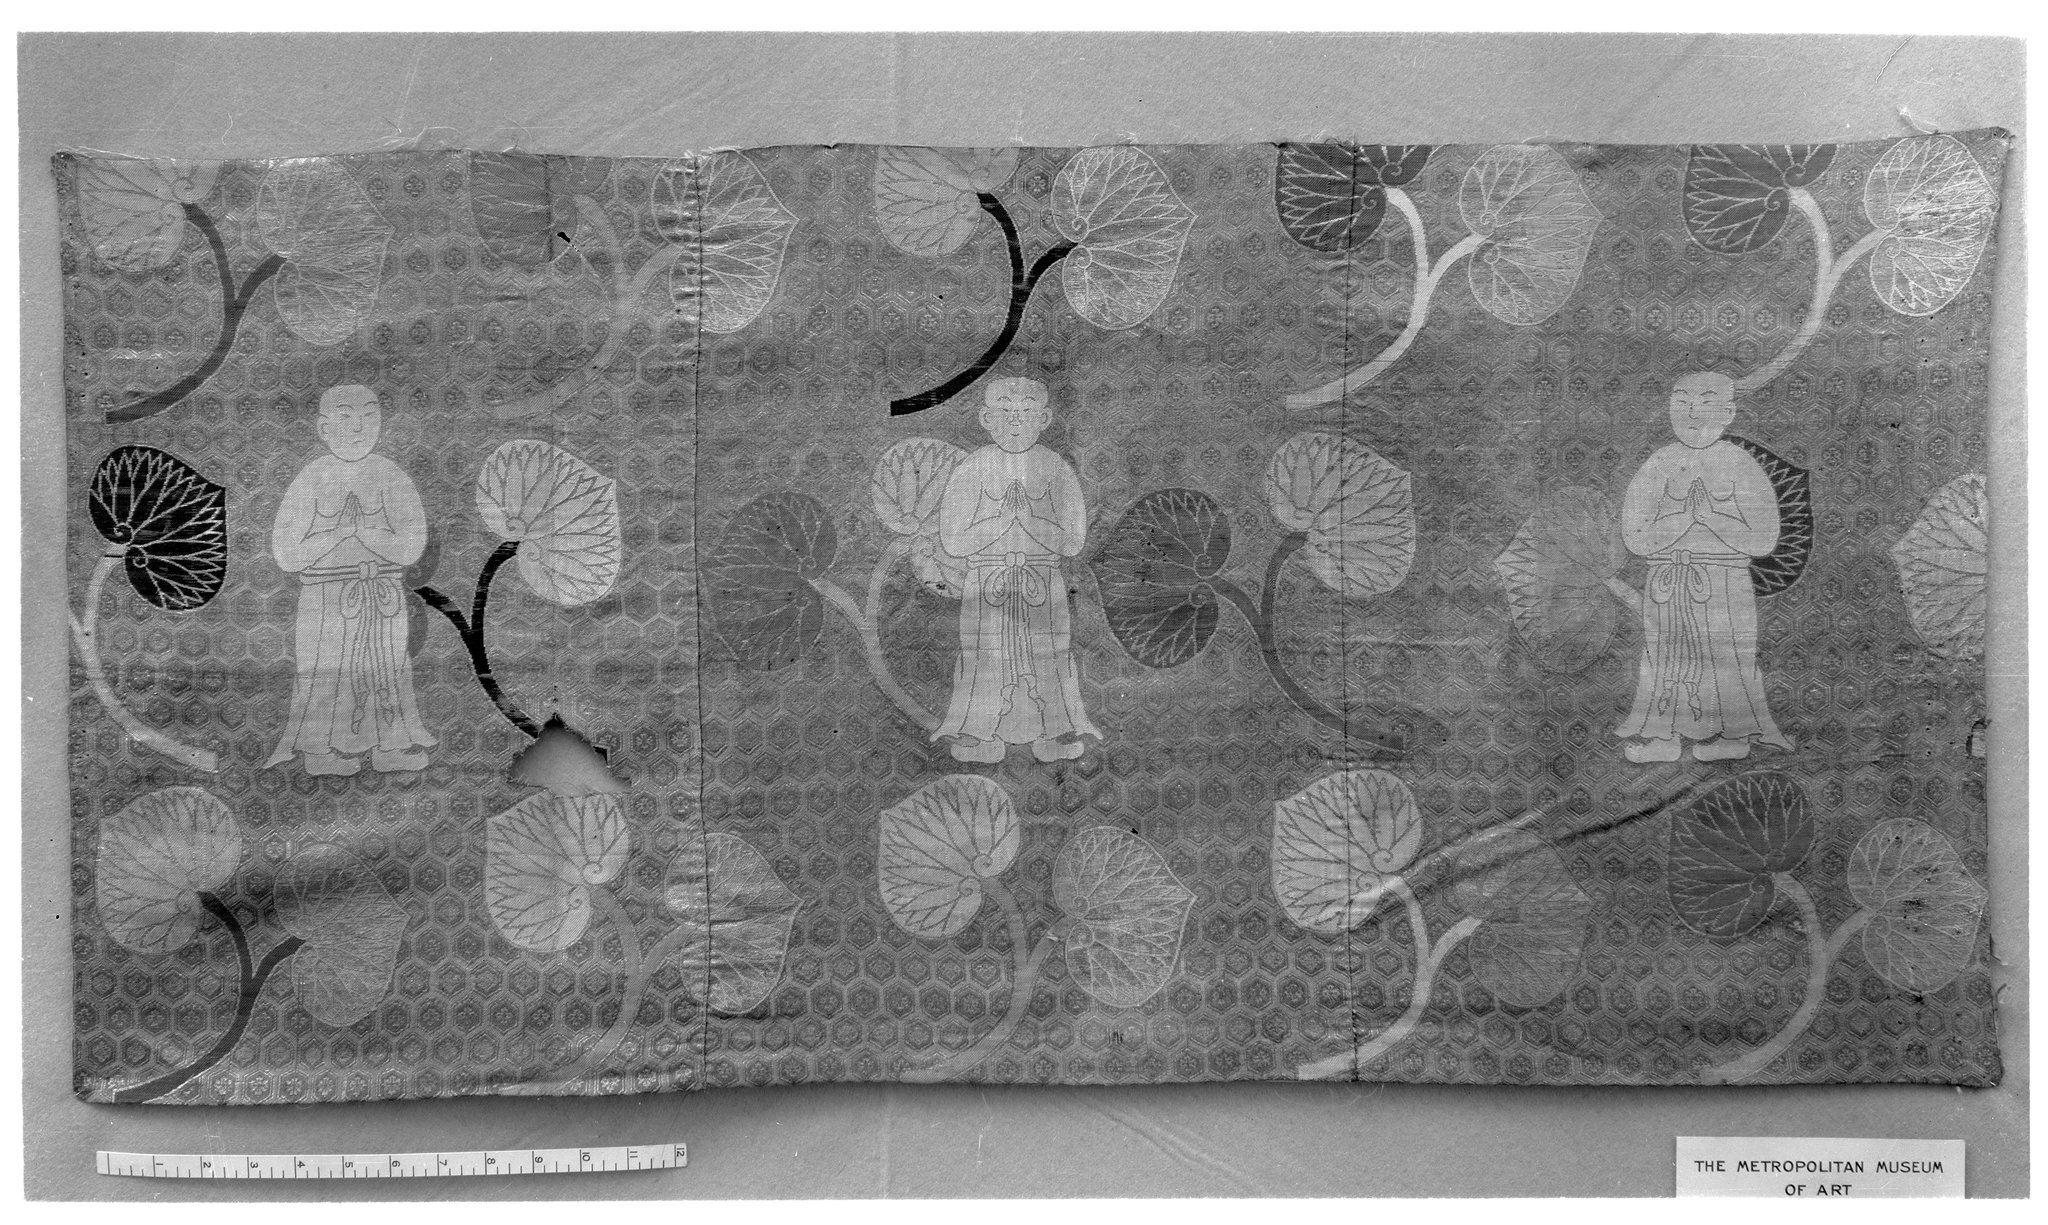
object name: piece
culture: japanese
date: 1701-1800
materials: metal thread, silk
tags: leaves